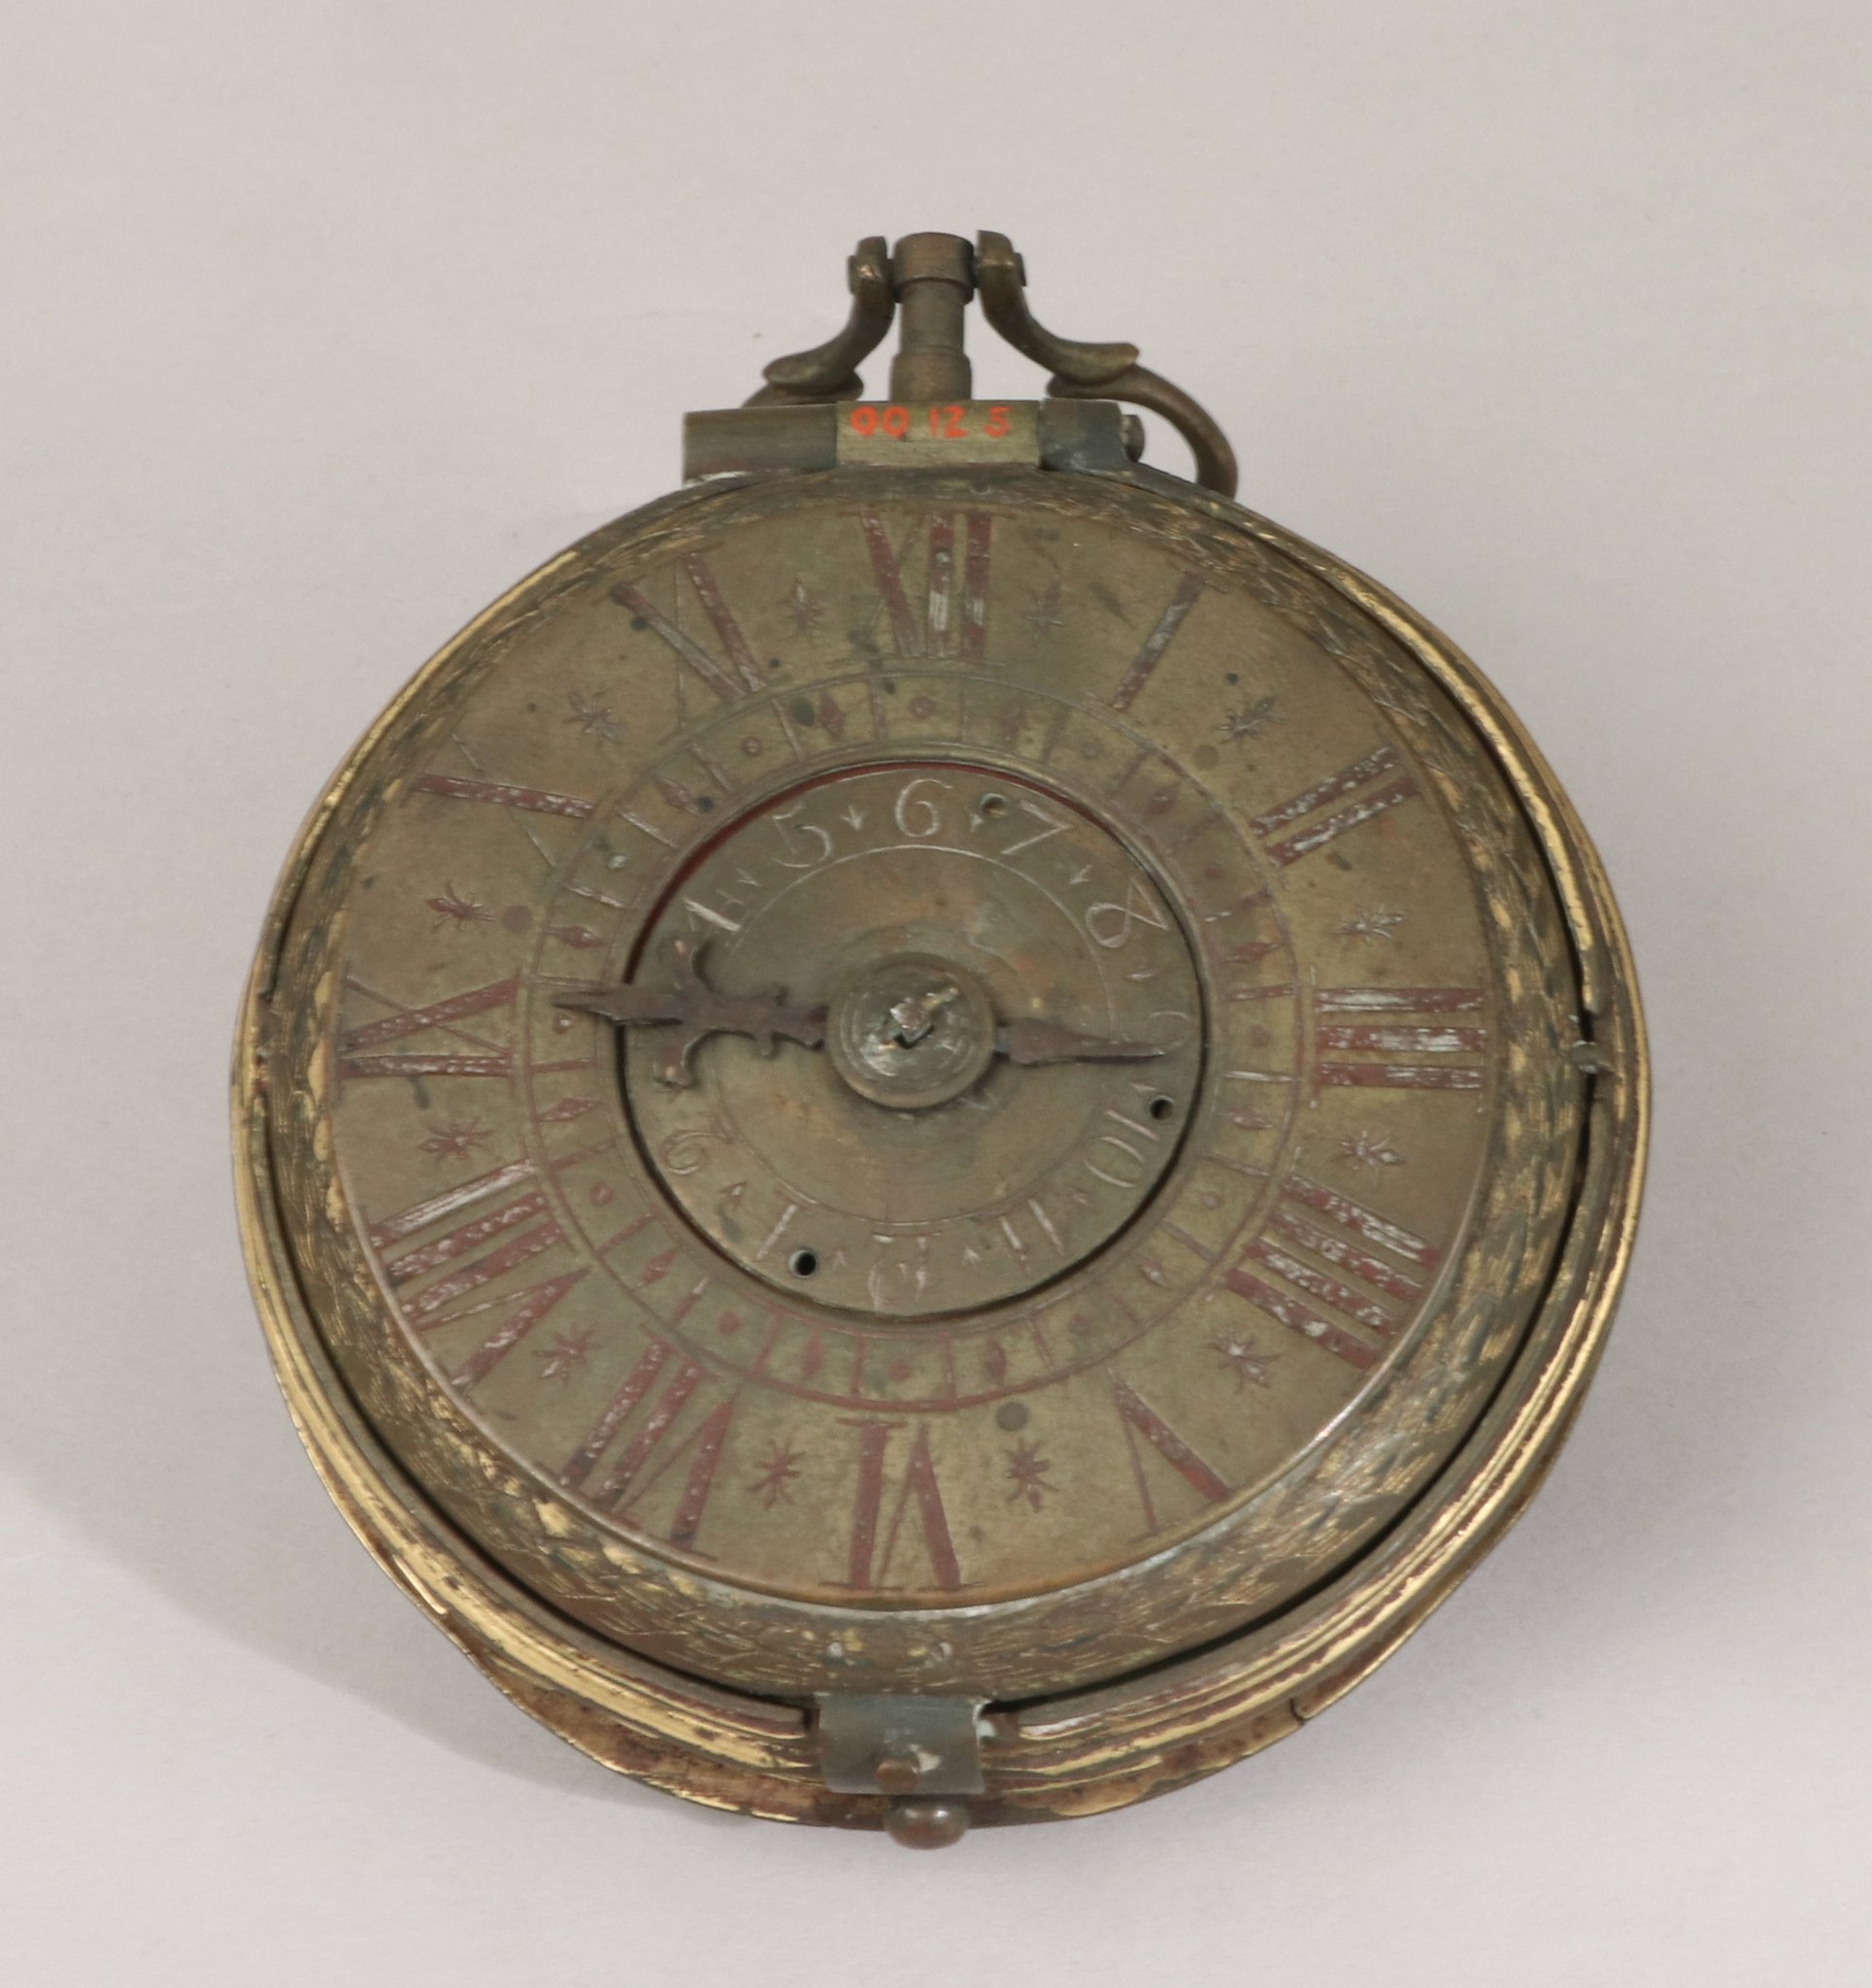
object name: clock watch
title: Clock-watch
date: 1650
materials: brass, gilt, steel